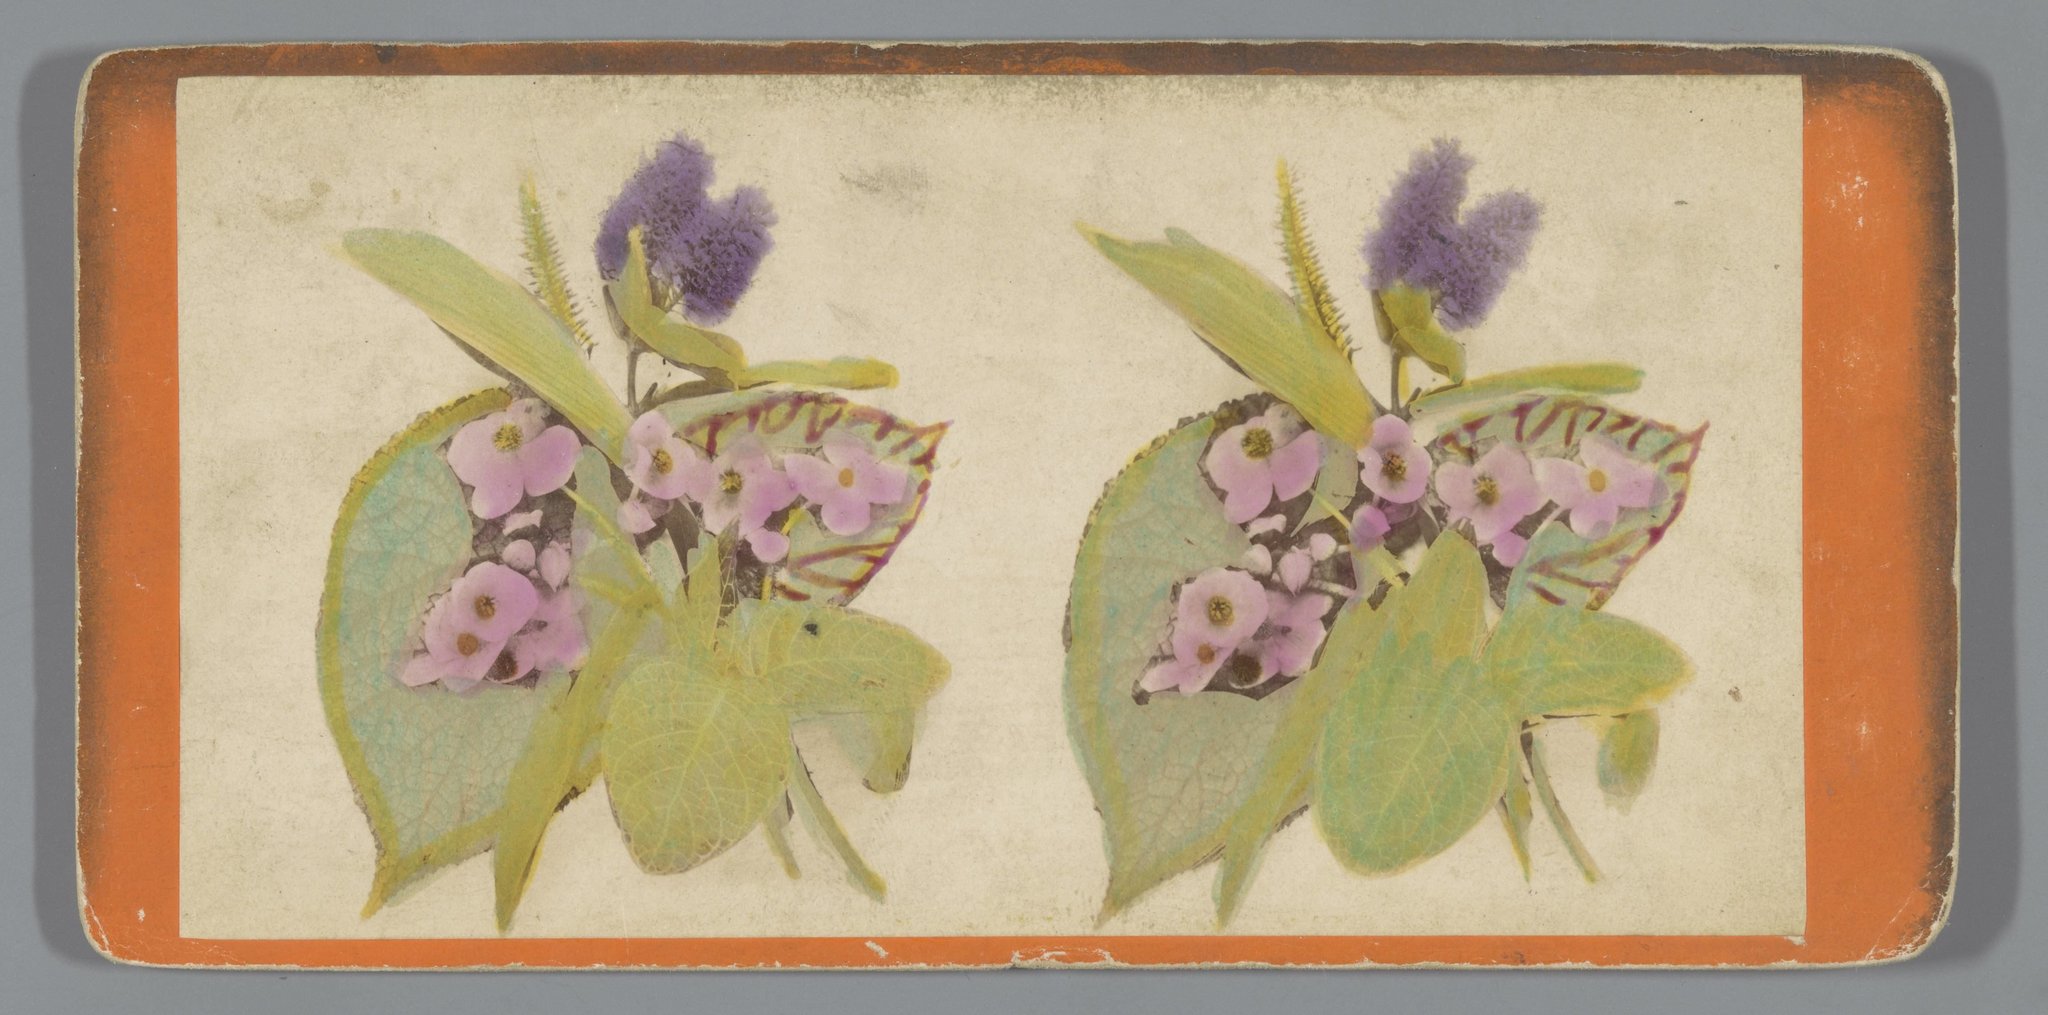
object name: stereograph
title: Stilleven met bladeren en bloemen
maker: Anonymous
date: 1855-1870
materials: cardboard, photographic support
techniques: albumen print, hand coloring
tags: cut flowers; nosegay, bunch of flowers